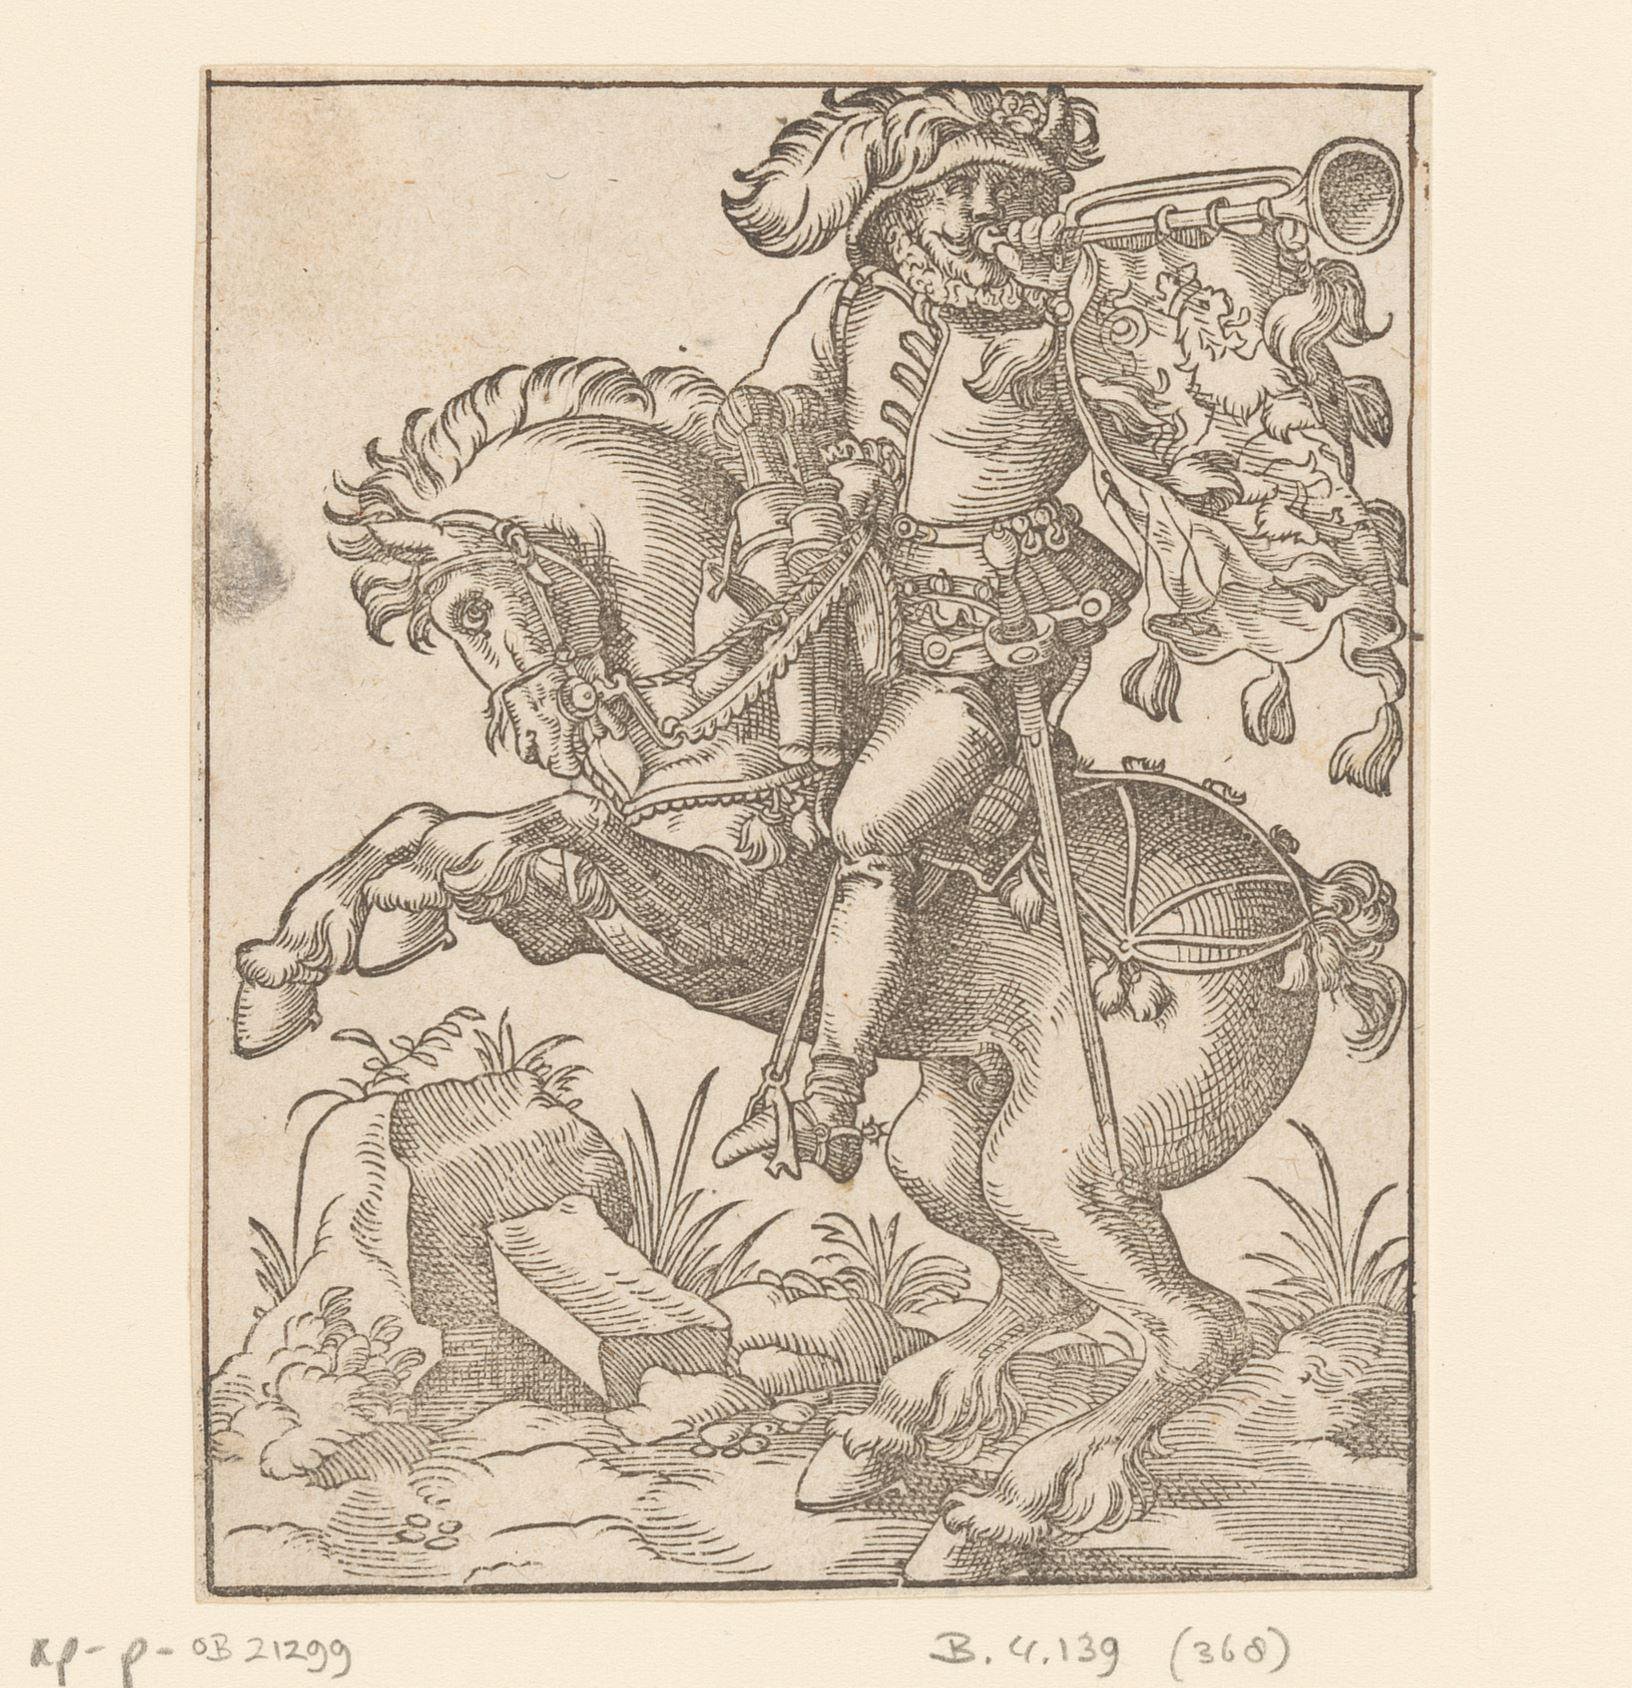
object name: print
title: Hoornblazende ruiter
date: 1580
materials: paper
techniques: woodcut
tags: riding a horse, ass, or mule; rider, horseman, horn, trumpet, cornet, trombone, tuba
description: Prent ook gebruikt in: Amman, Jost. Kunstbüchlein. Frankfurt am Main: Feyerabend, 1580.